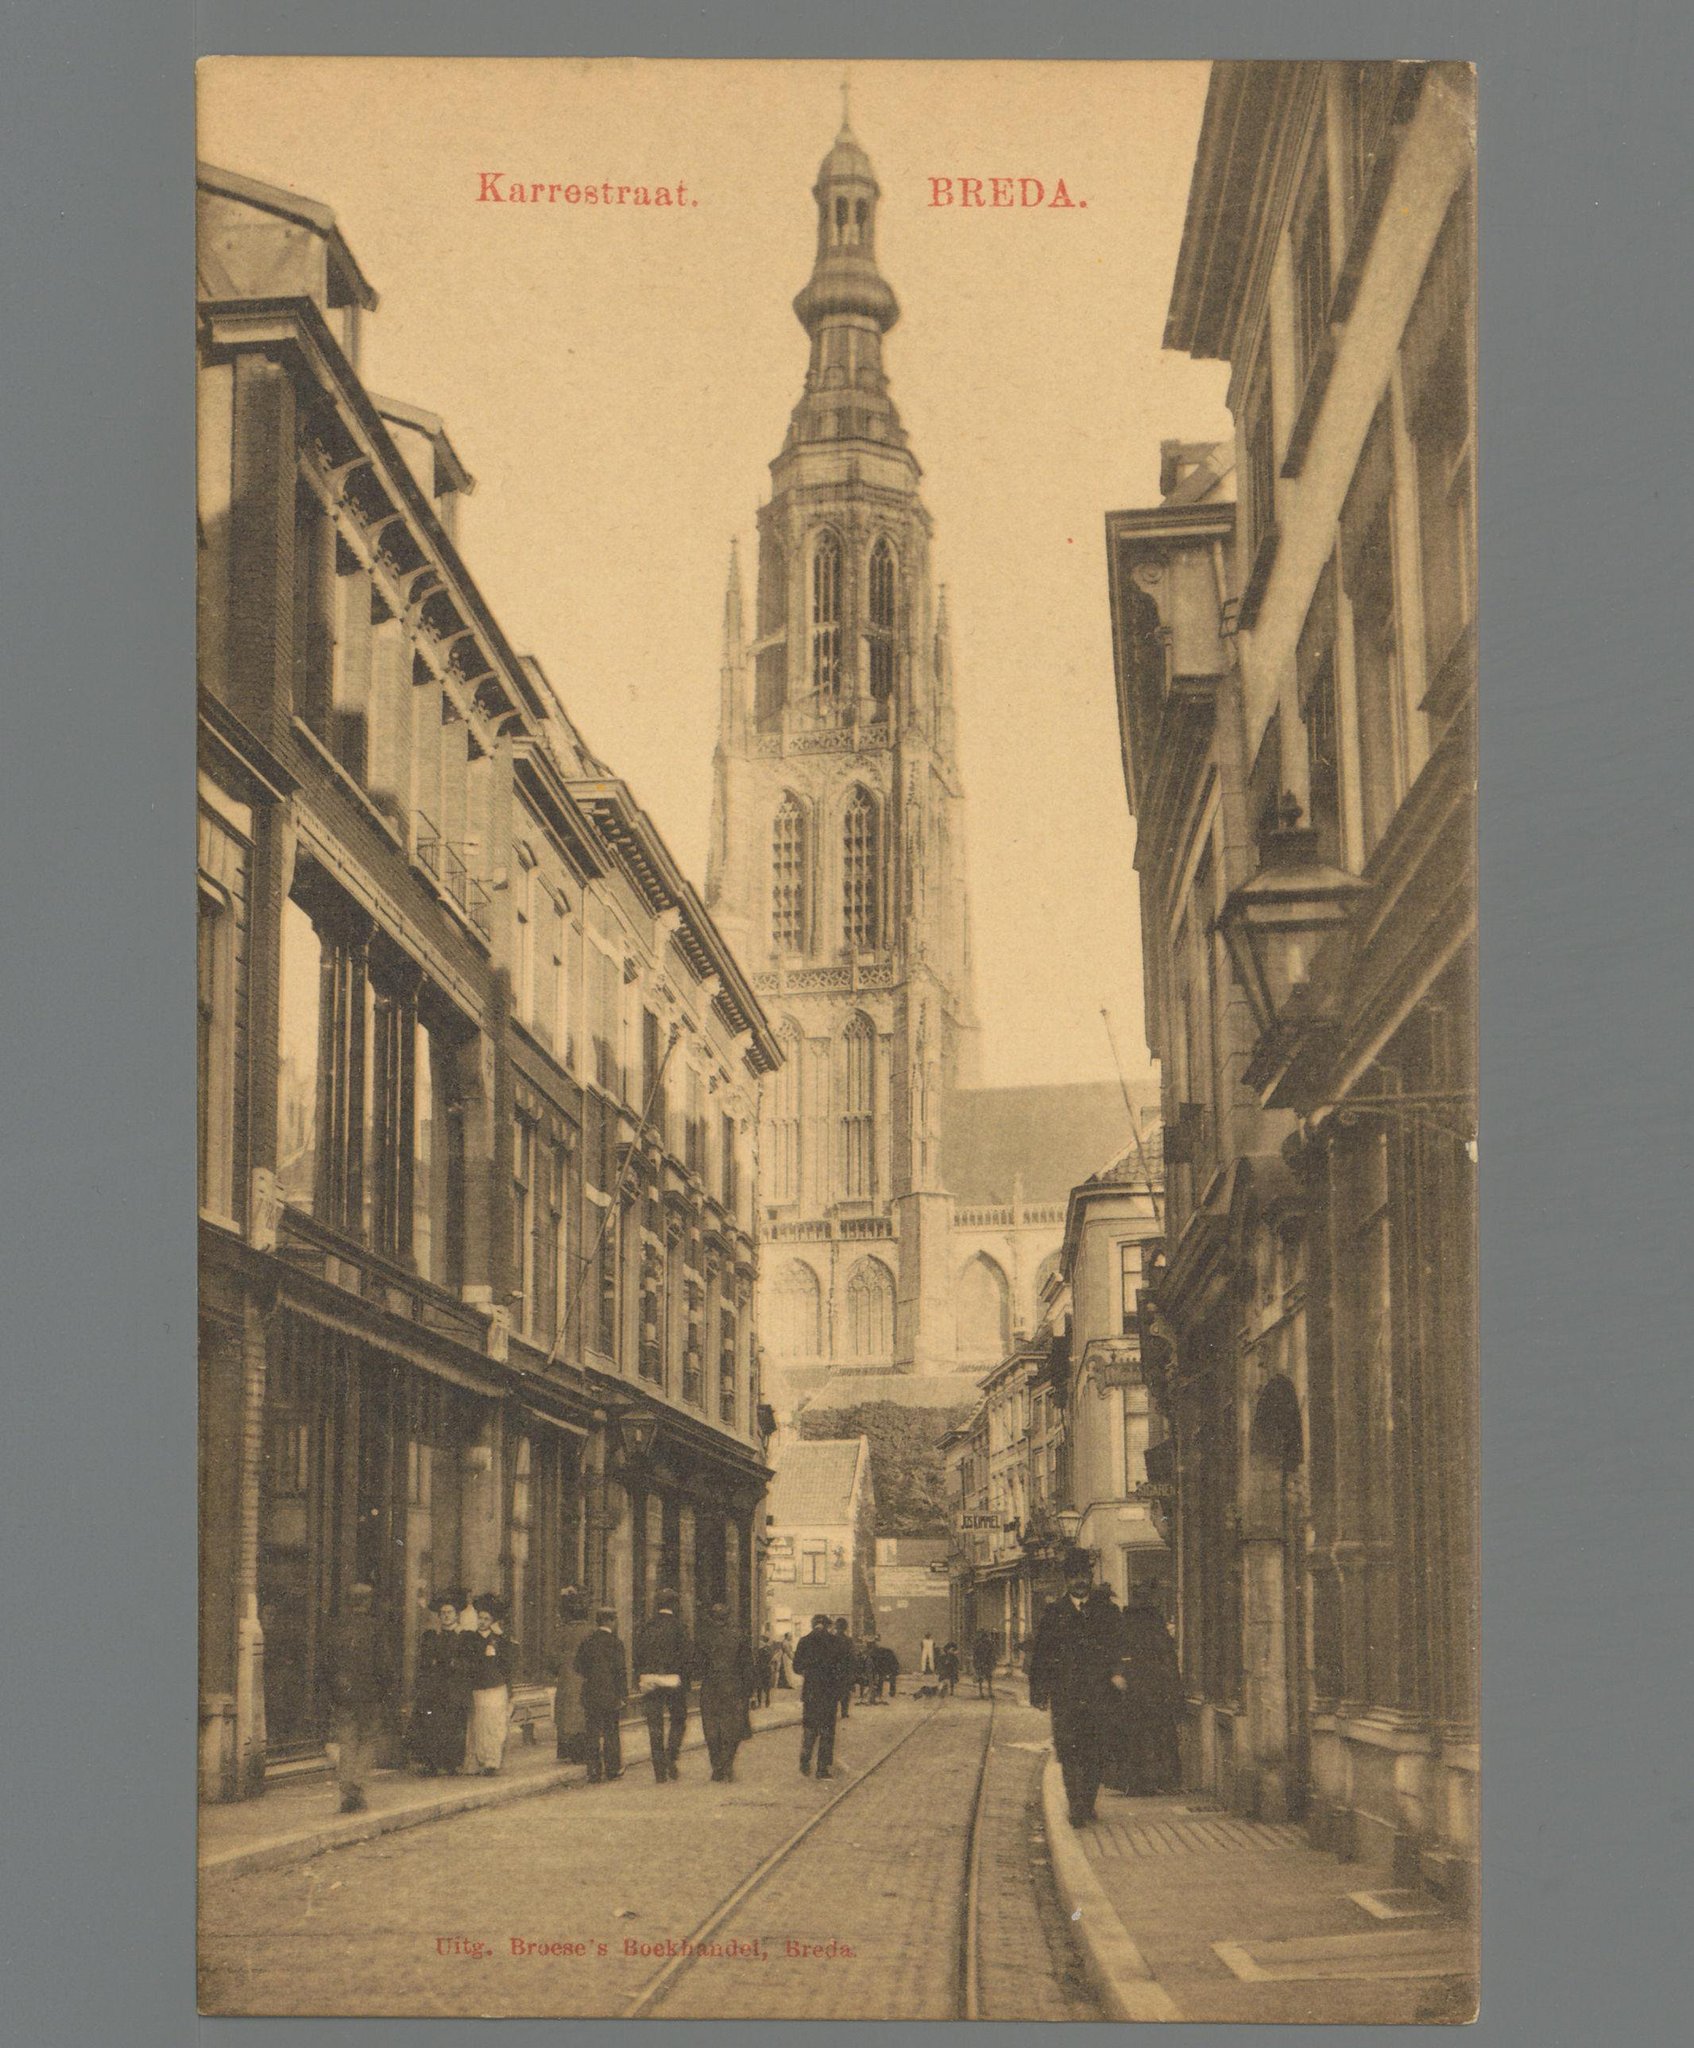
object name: ansichtkaart, prentbriefkaart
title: Karrestraat. Breda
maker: Anonymous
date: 1905-1927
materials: cardboard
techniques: photograph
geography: haarlem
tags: church (exterior), street